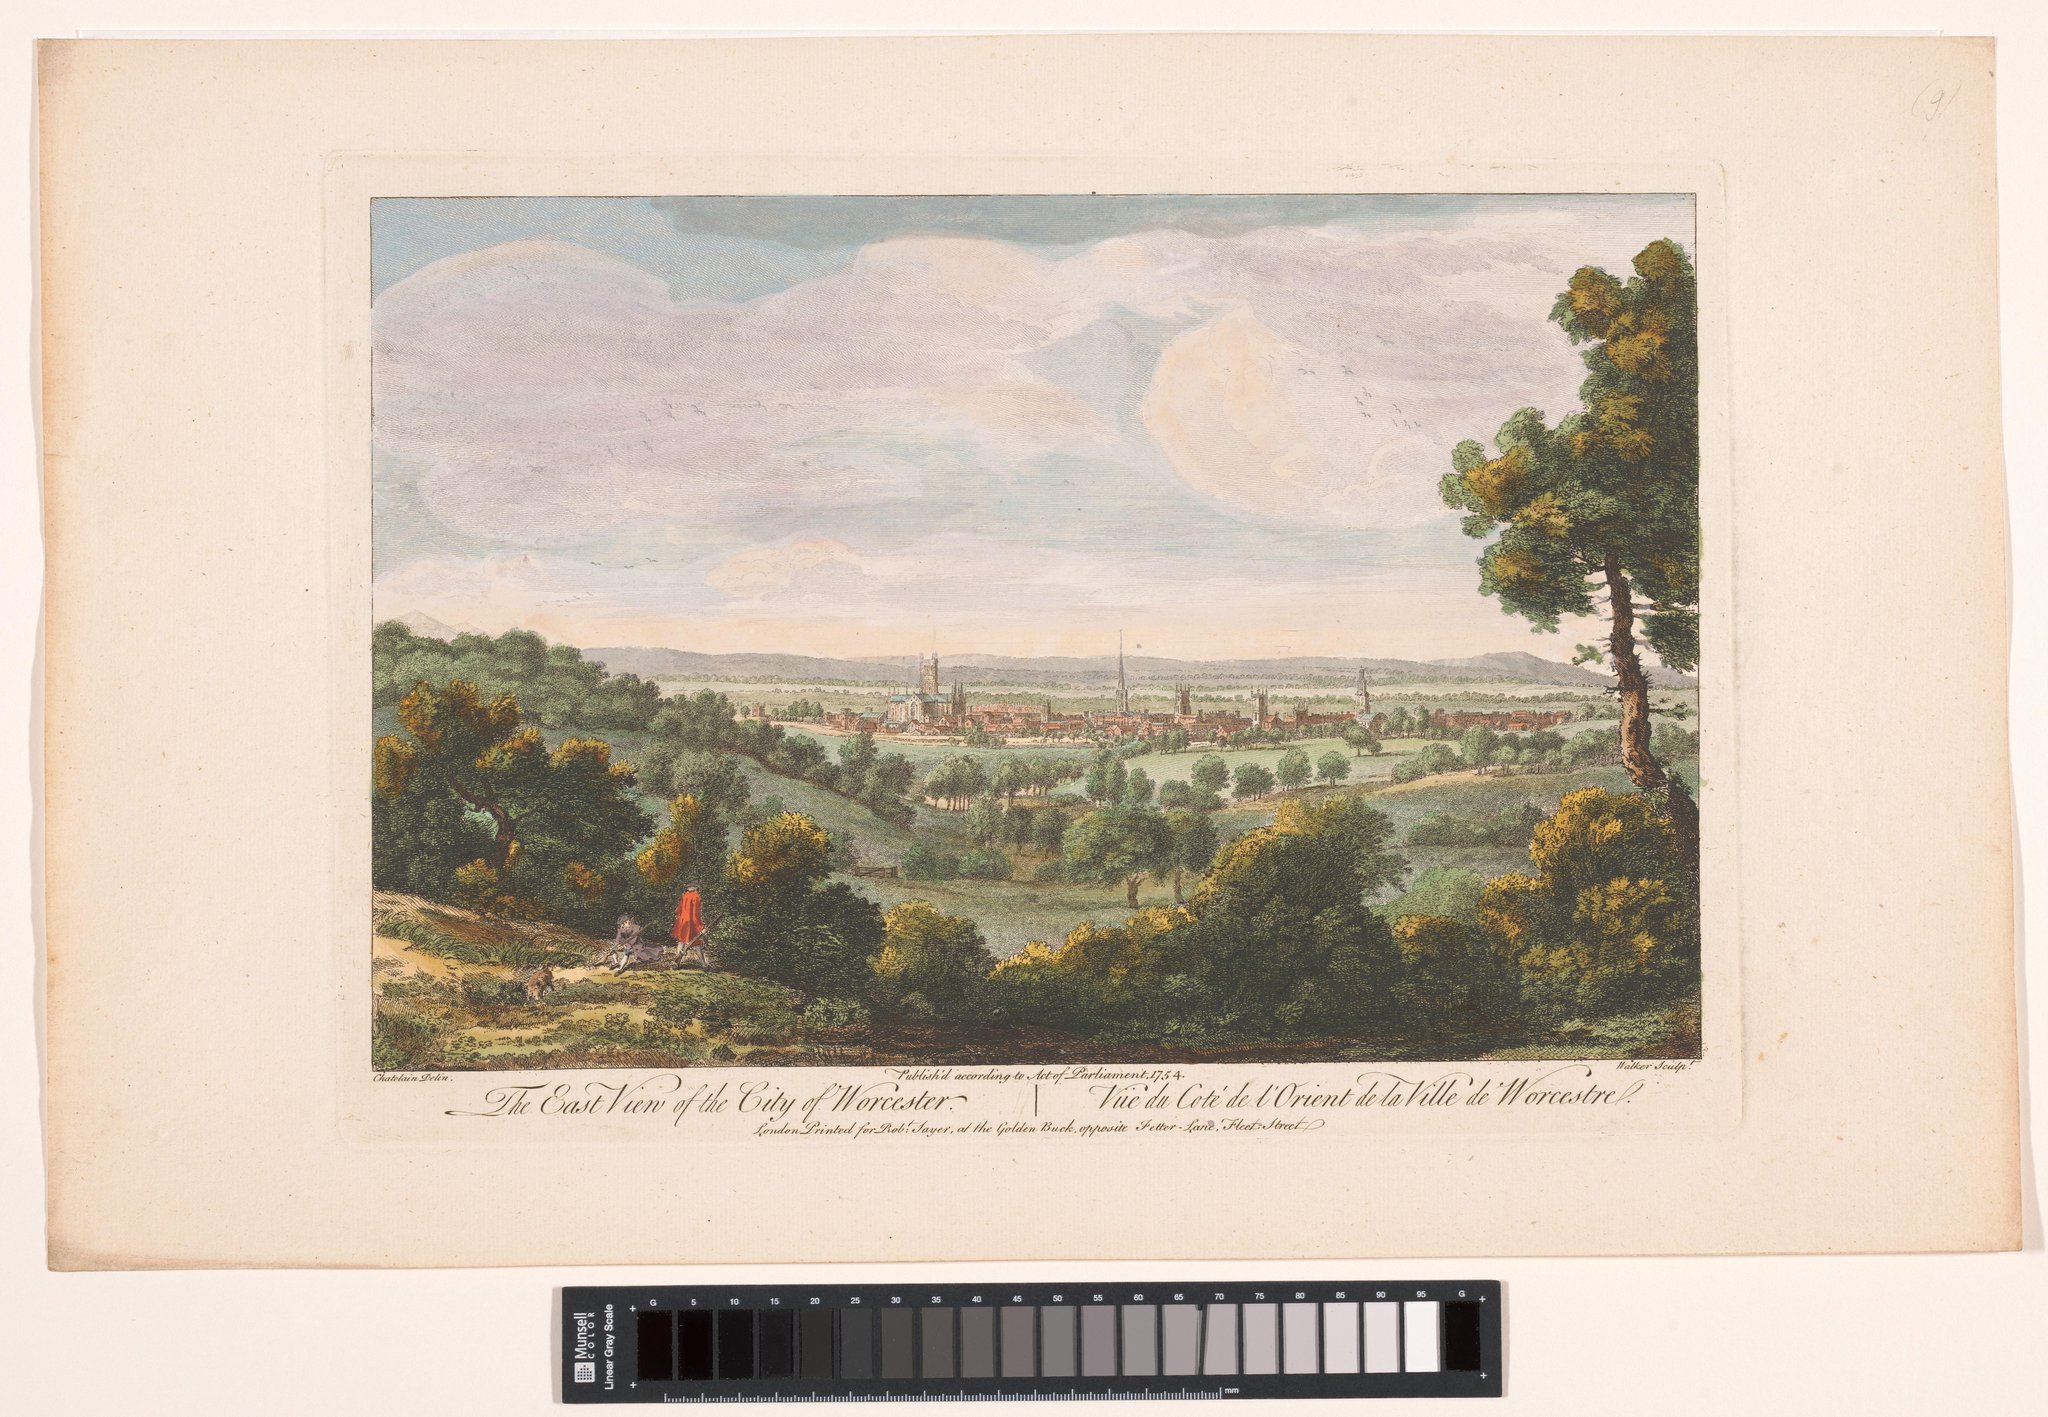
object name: print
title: The north west view of the city of Worcester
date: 1754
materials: paper, watercolor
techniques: brush, etching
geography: london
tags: city-view in general; 'veduta' (+ city(-scape) with figures, staffage), canals, waters (in city) (+ city(-scape) with figures, staffage)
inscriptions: date